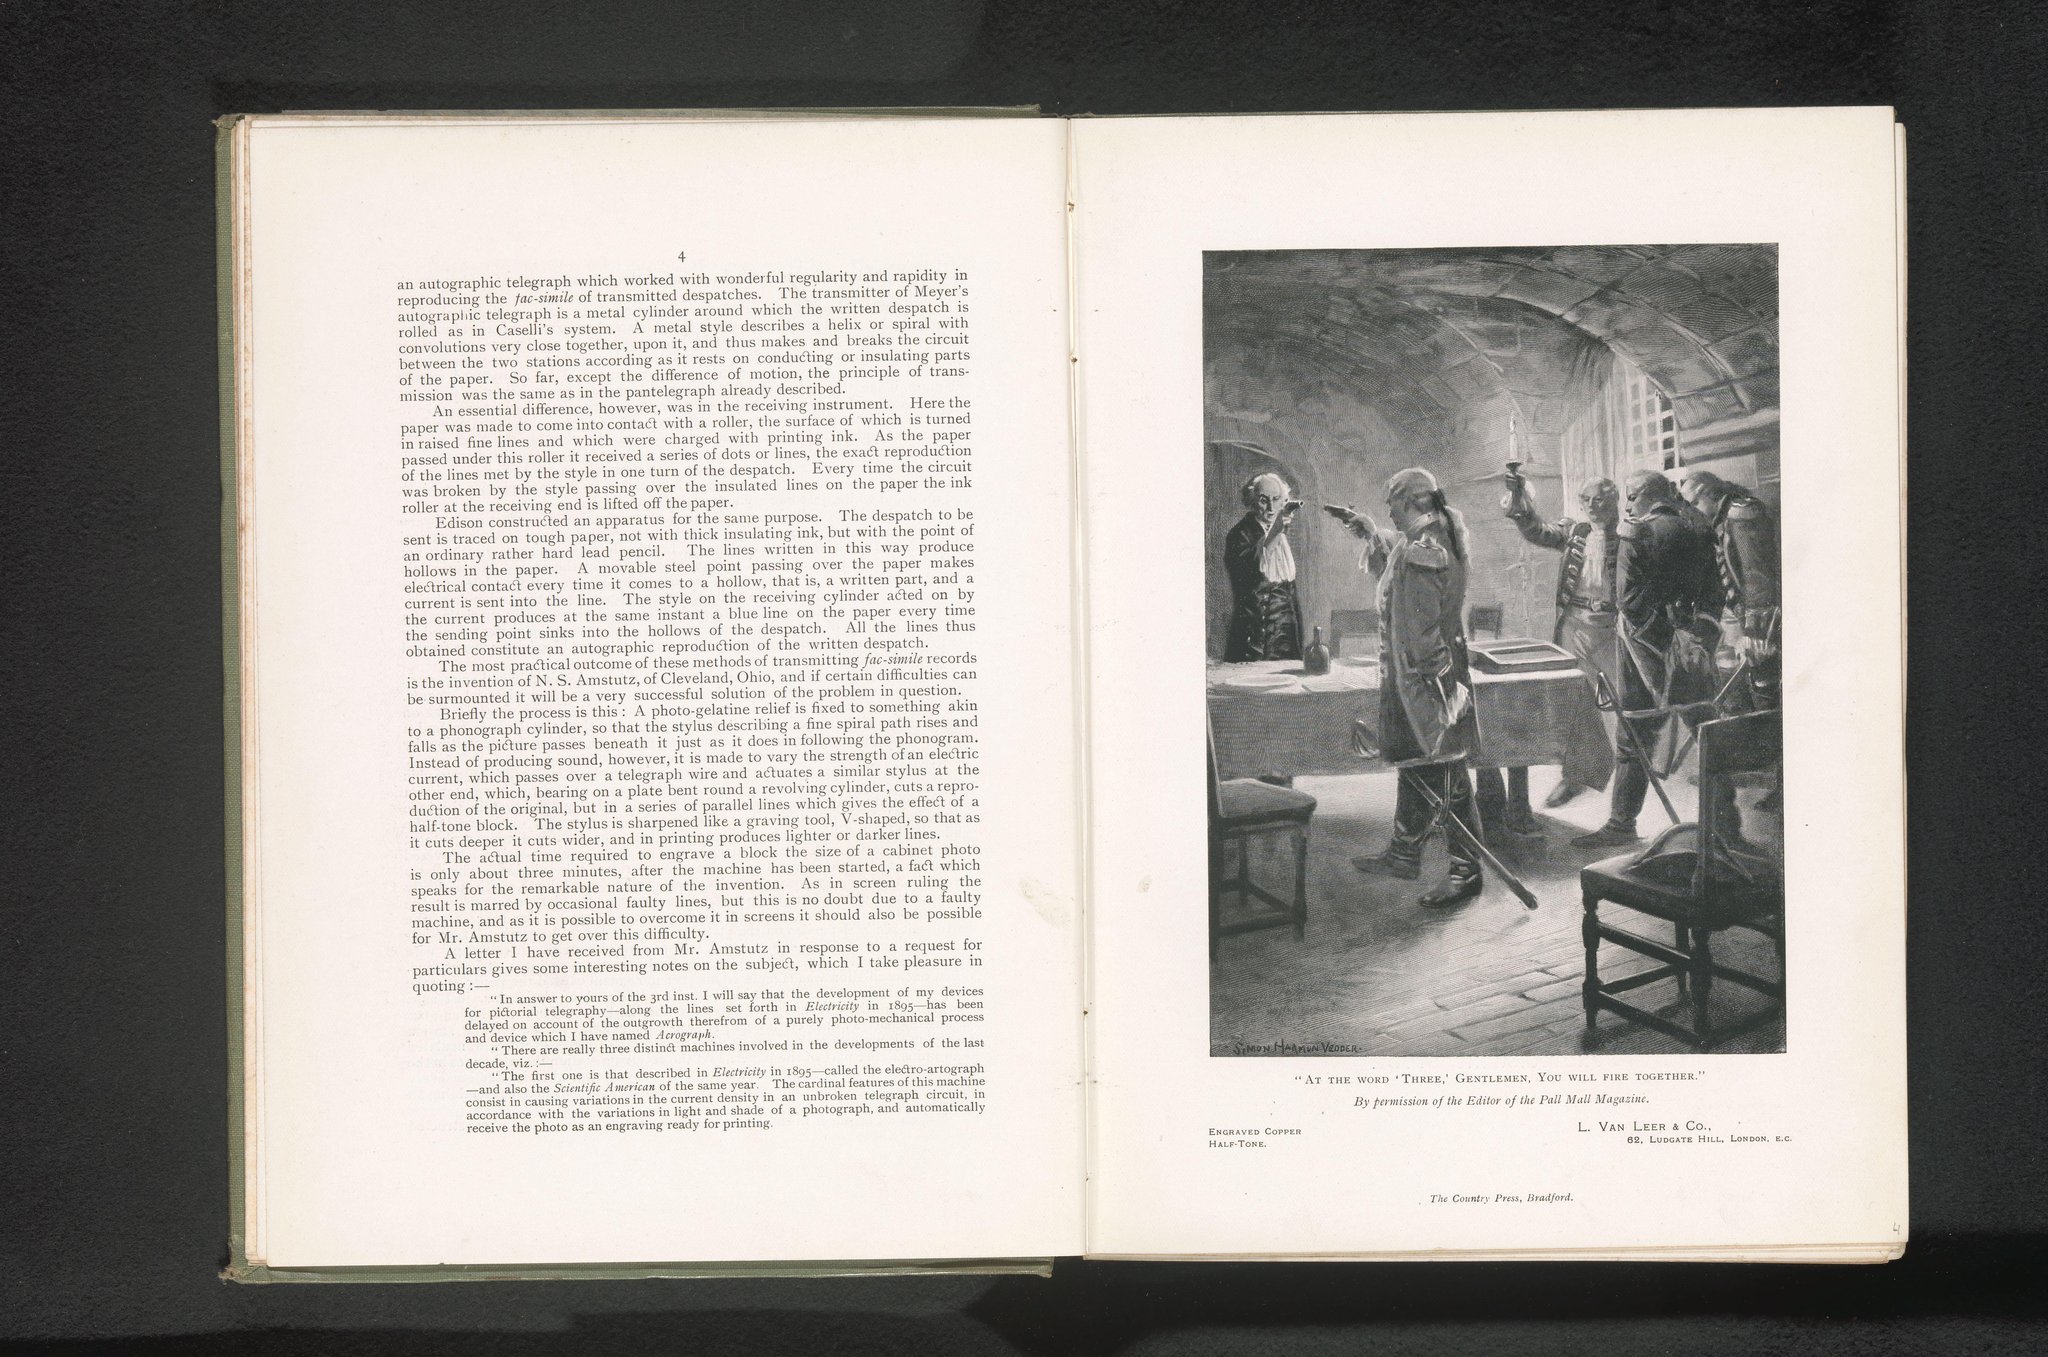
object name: page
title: Reproductie van een schilderij met duellerende mannen door Simon Harmon Vedder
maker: simon harmon vedder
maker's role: painter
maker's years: 1866-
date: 1893-1898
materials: paper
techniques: autotype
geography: london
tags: duel in place of battle